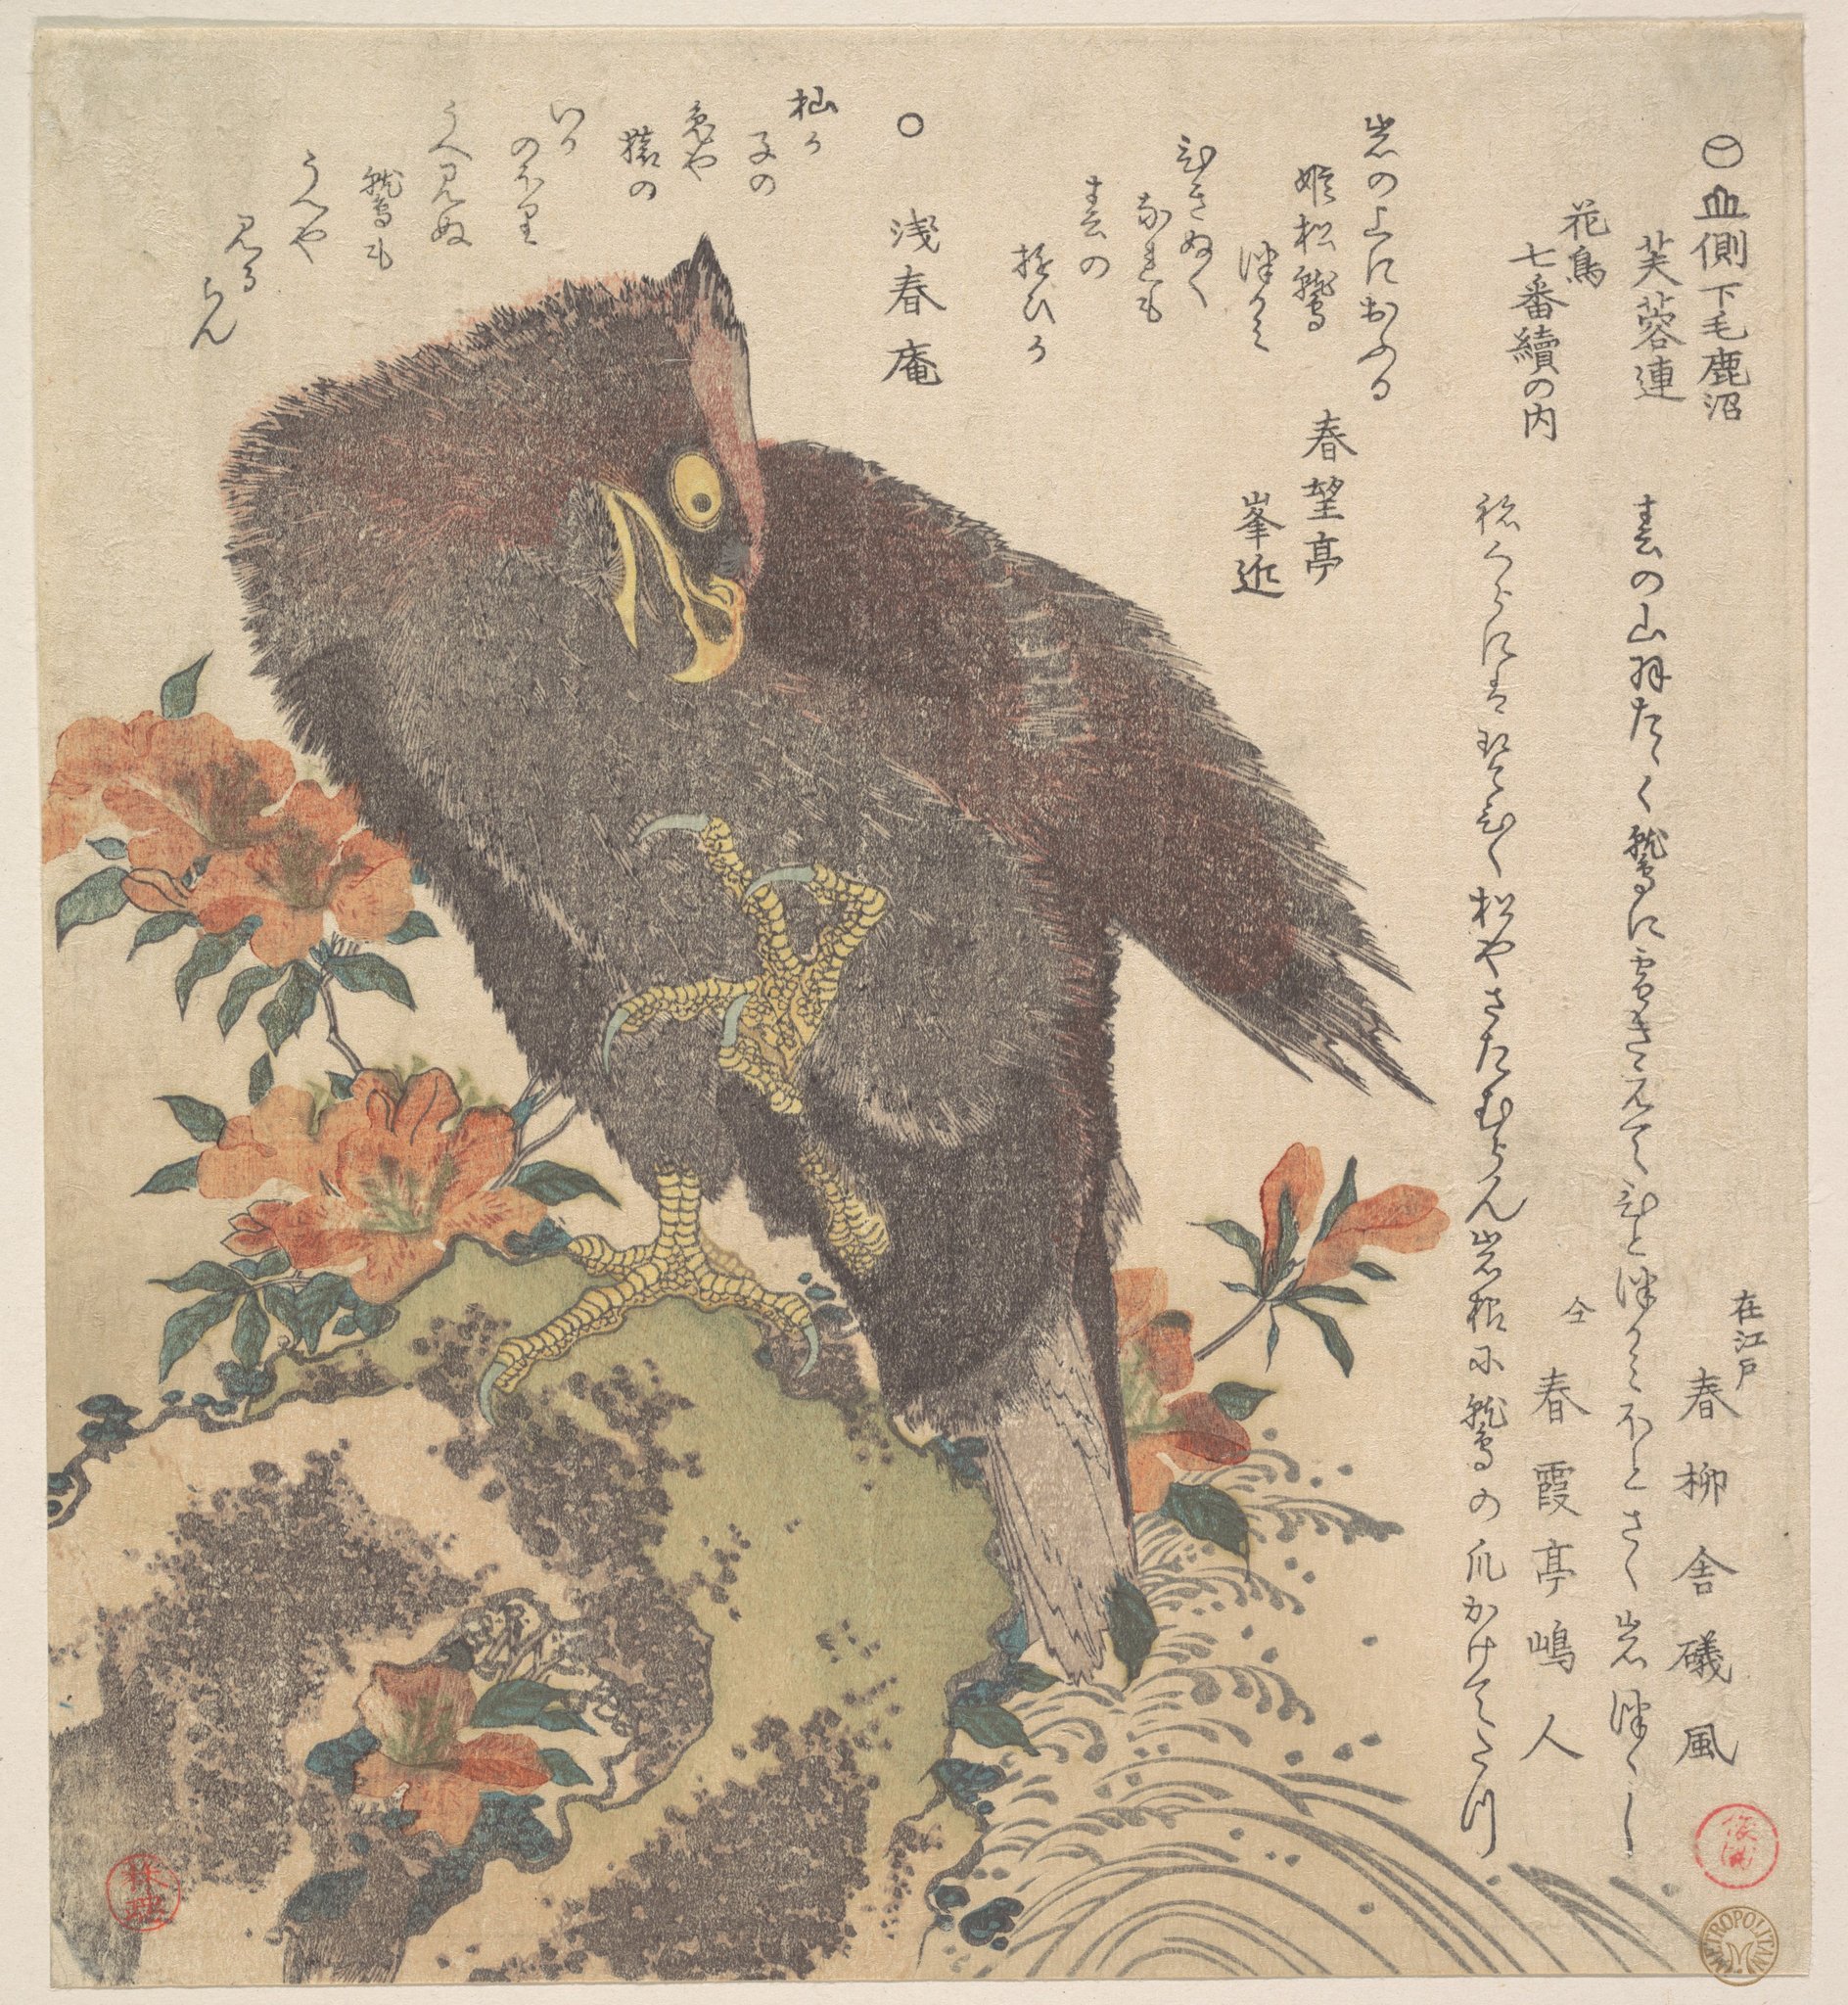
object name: print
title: Eagle on a Rock; Flowering Azaleas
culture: japanese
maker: kubo shunman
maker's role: artist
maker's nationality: japanese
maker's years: 1757-1820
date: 1800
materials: ink, paper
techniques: surimono, woodblock print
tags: eagles,flowers